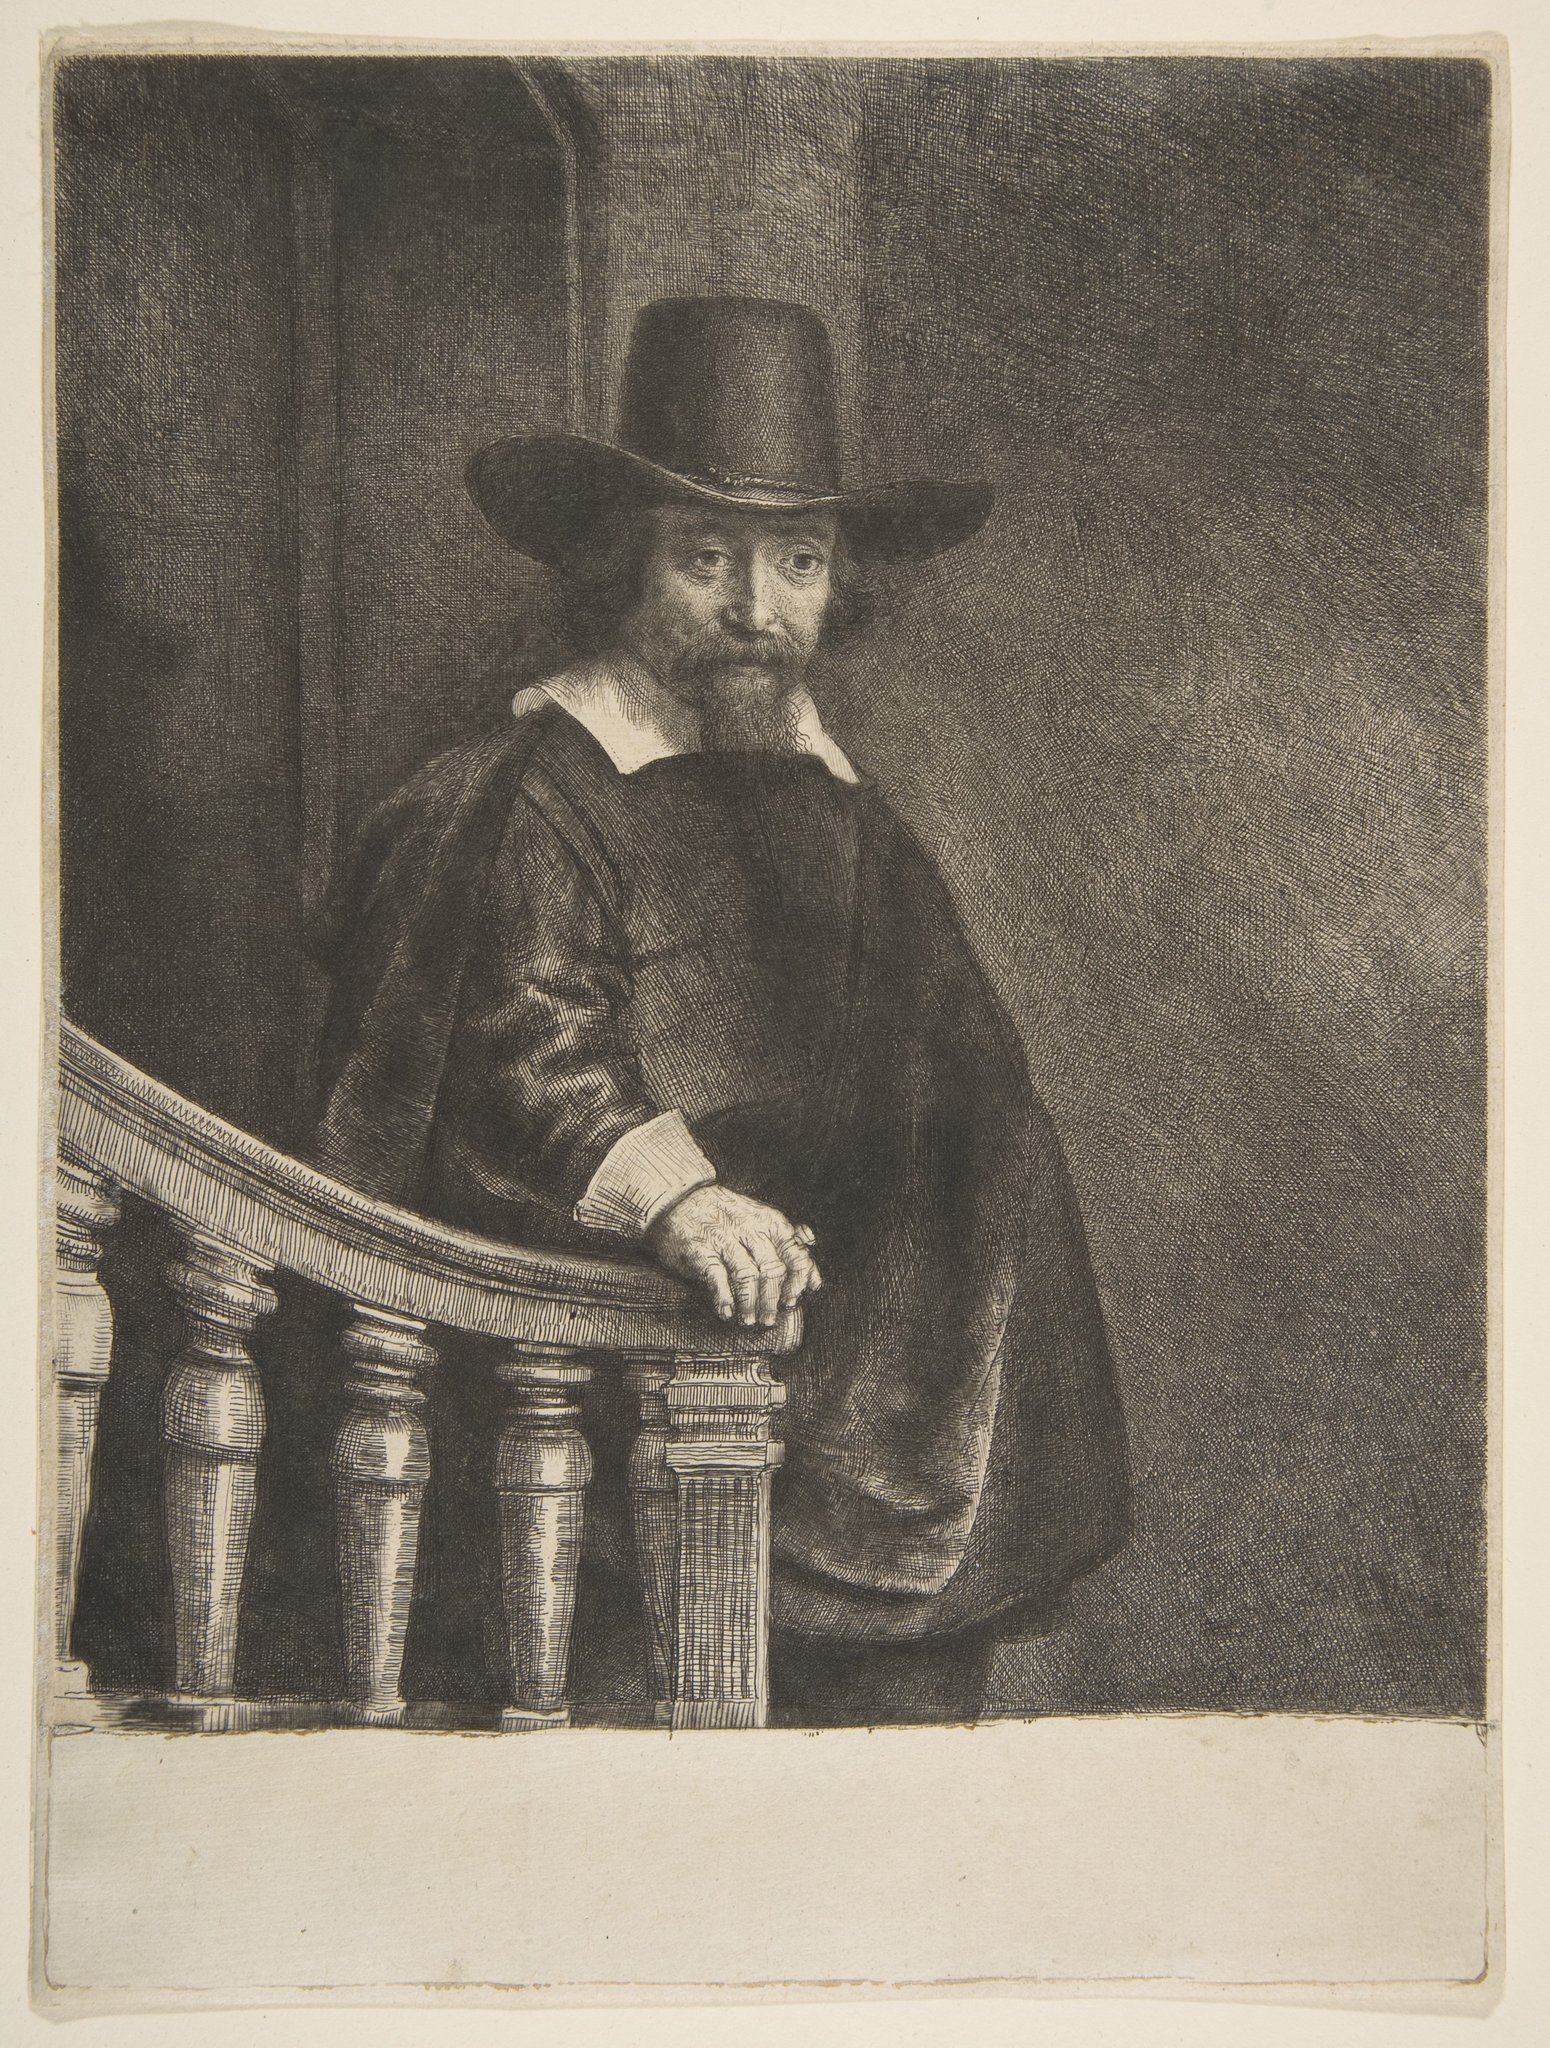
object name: print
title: Ephraim Bonus, Jewish Physician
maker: rembrandt van rijn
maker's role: artist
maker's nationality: dutch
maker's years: 1606-1669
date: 1641-1651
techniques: drypoint, engraving, etching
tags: men,portraits,doctors